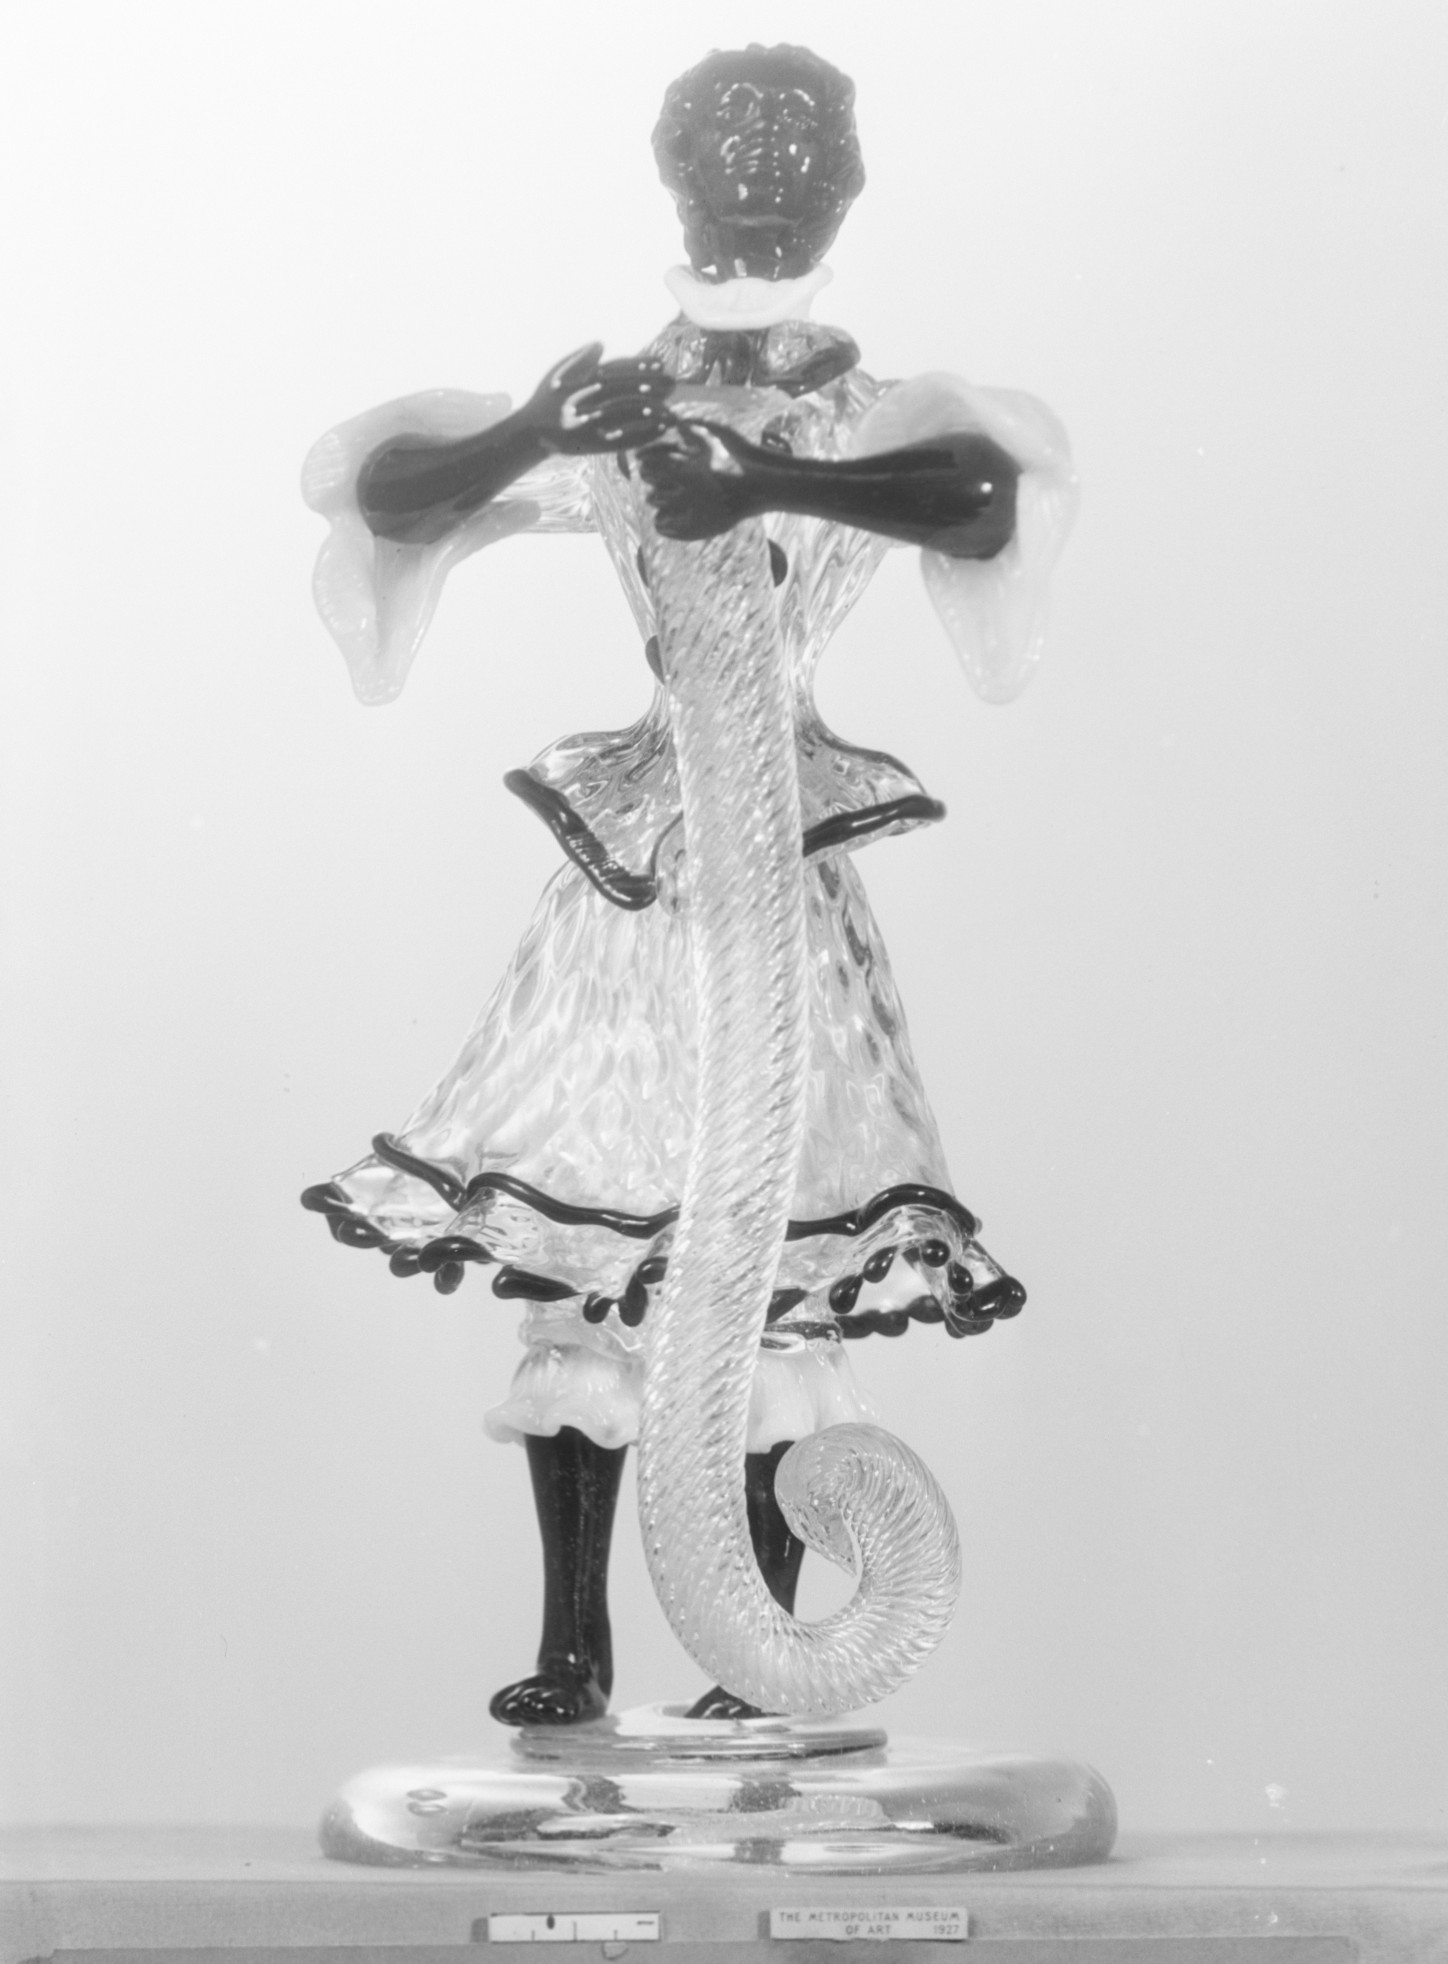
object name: lamp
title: Lamp (one of a pair)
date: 1701-1800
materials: glass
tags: women